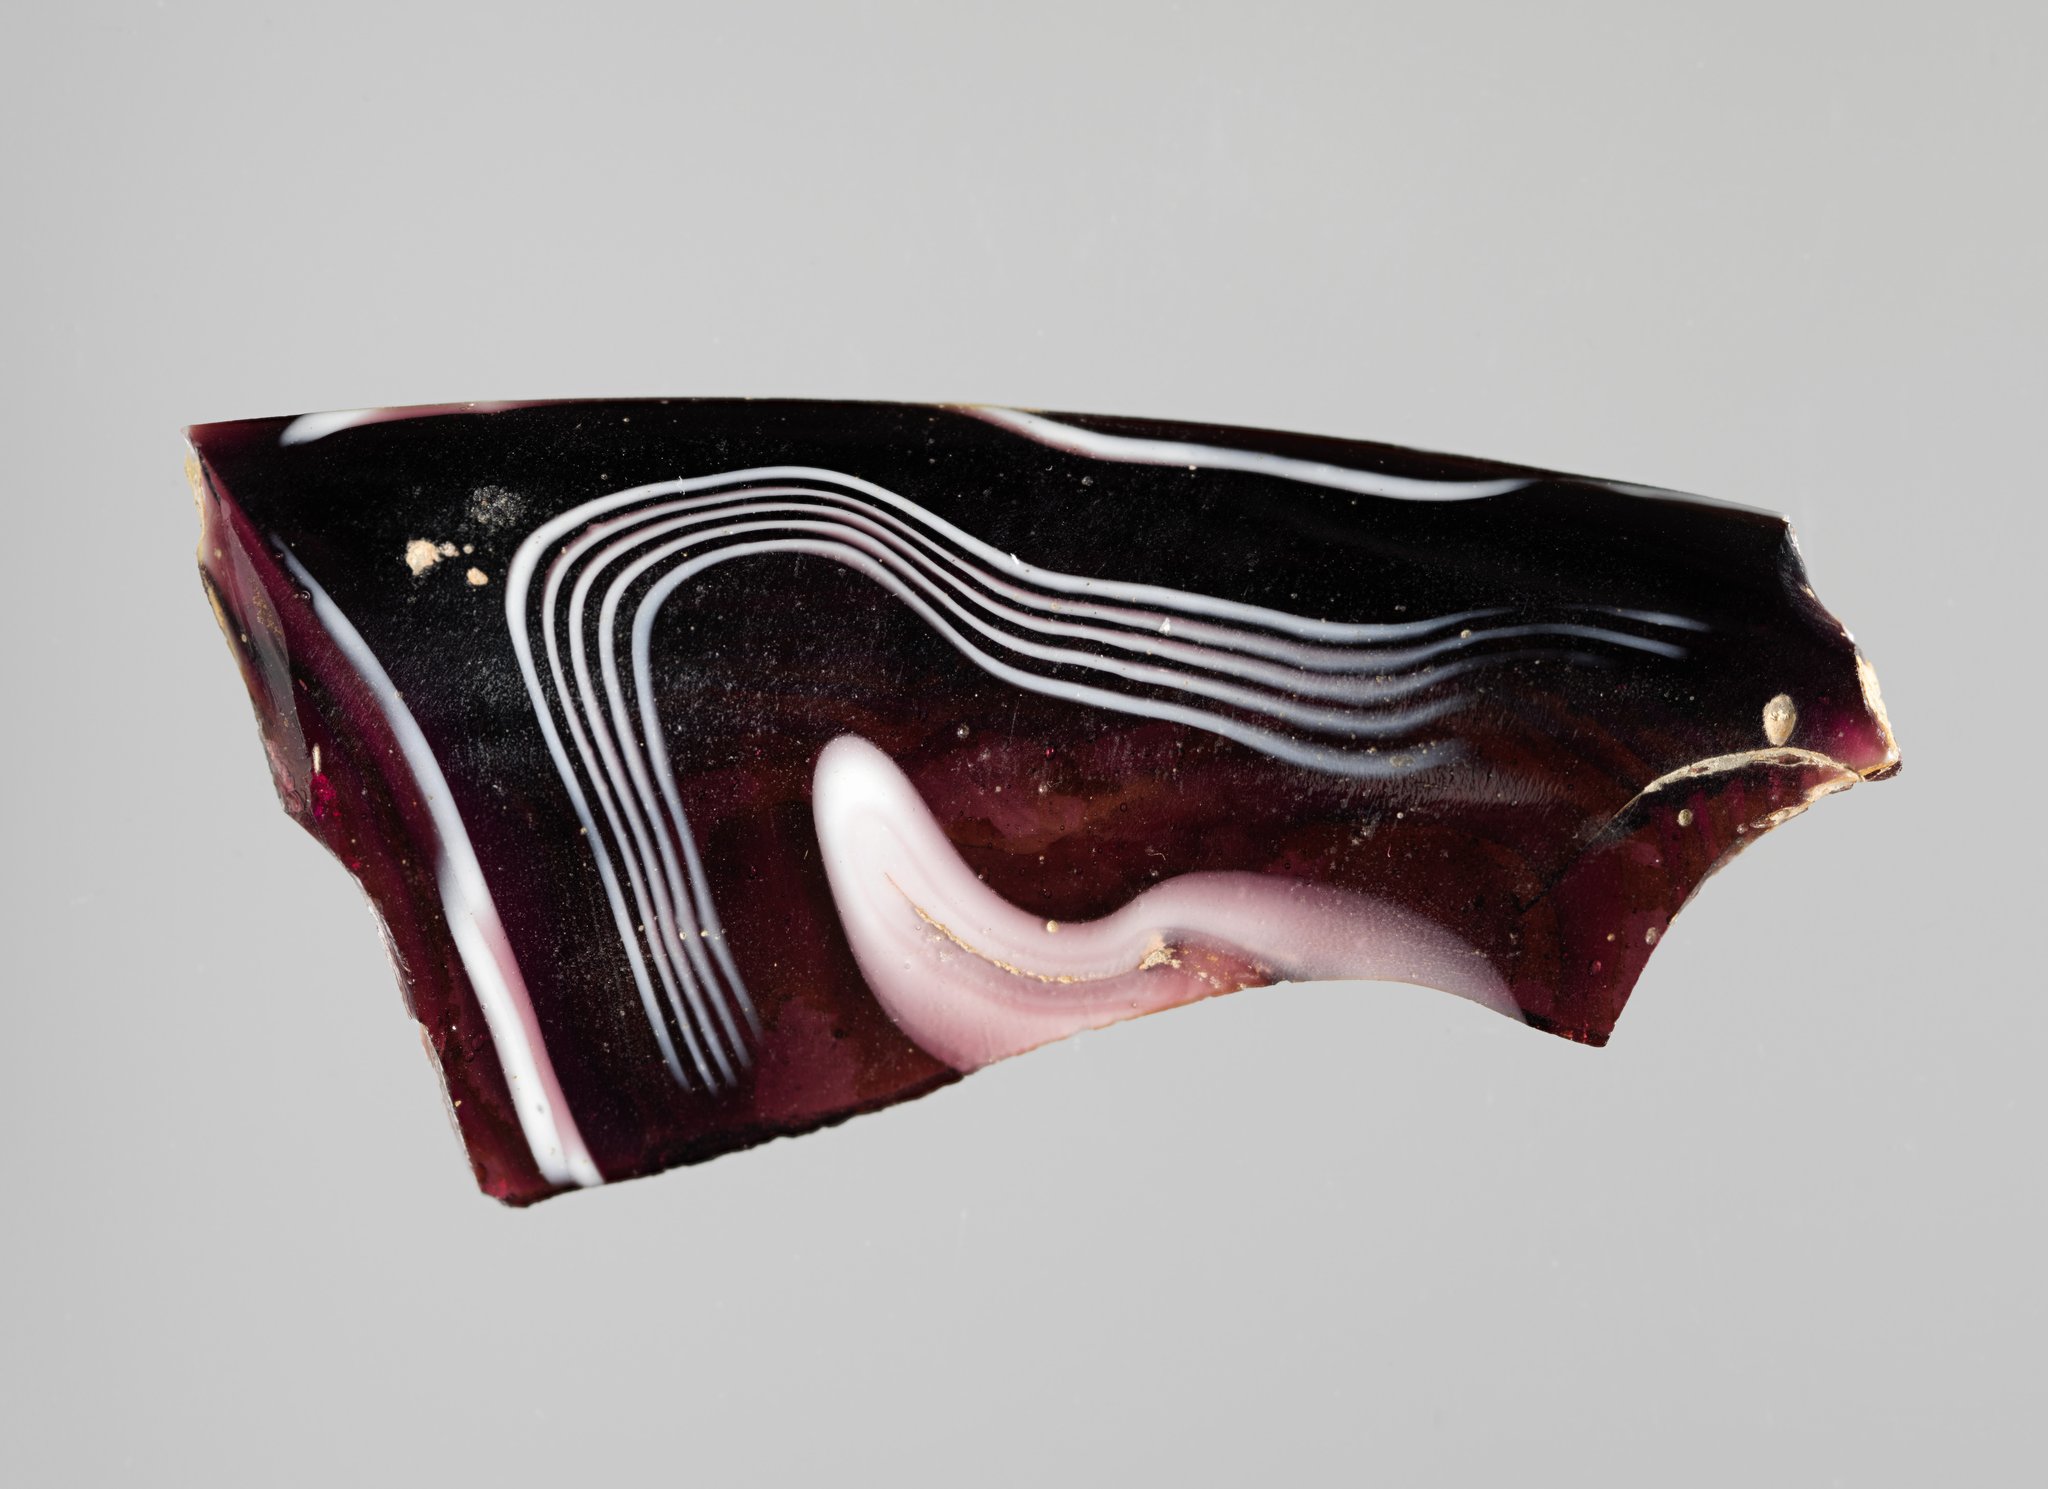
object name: fragment, mosaic bowl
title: Glass mosaic ribbed bowl fragment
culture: roman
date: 34 BCE-33 CE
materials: glass